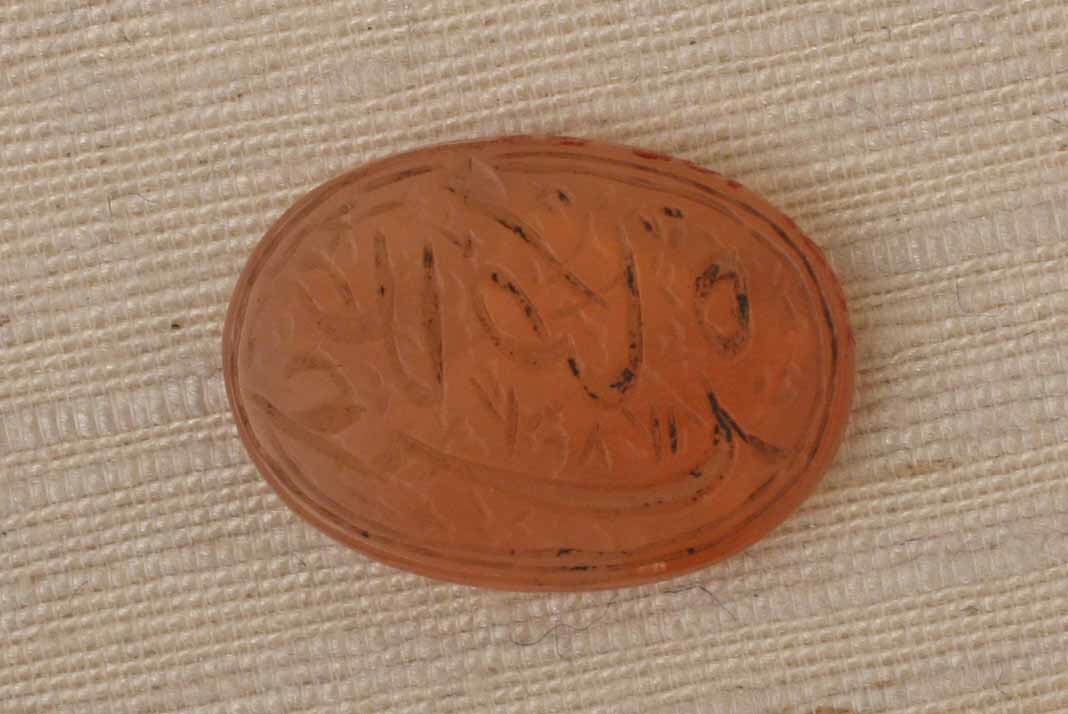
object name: stamp seal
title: Seal Stamp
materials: stone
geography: iran